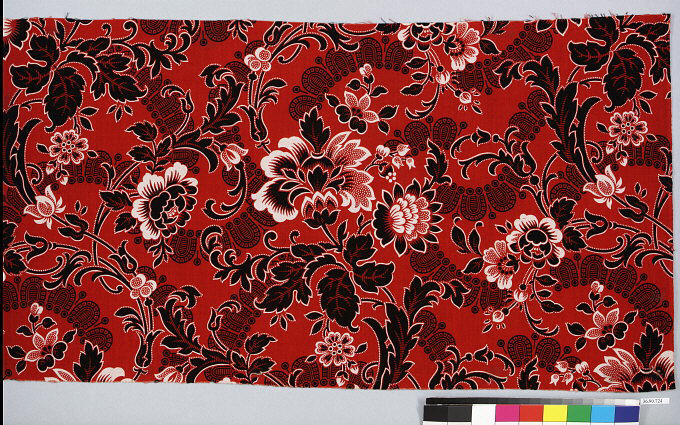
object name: piece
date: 1867-1900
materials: cotton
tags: flowers,leaves